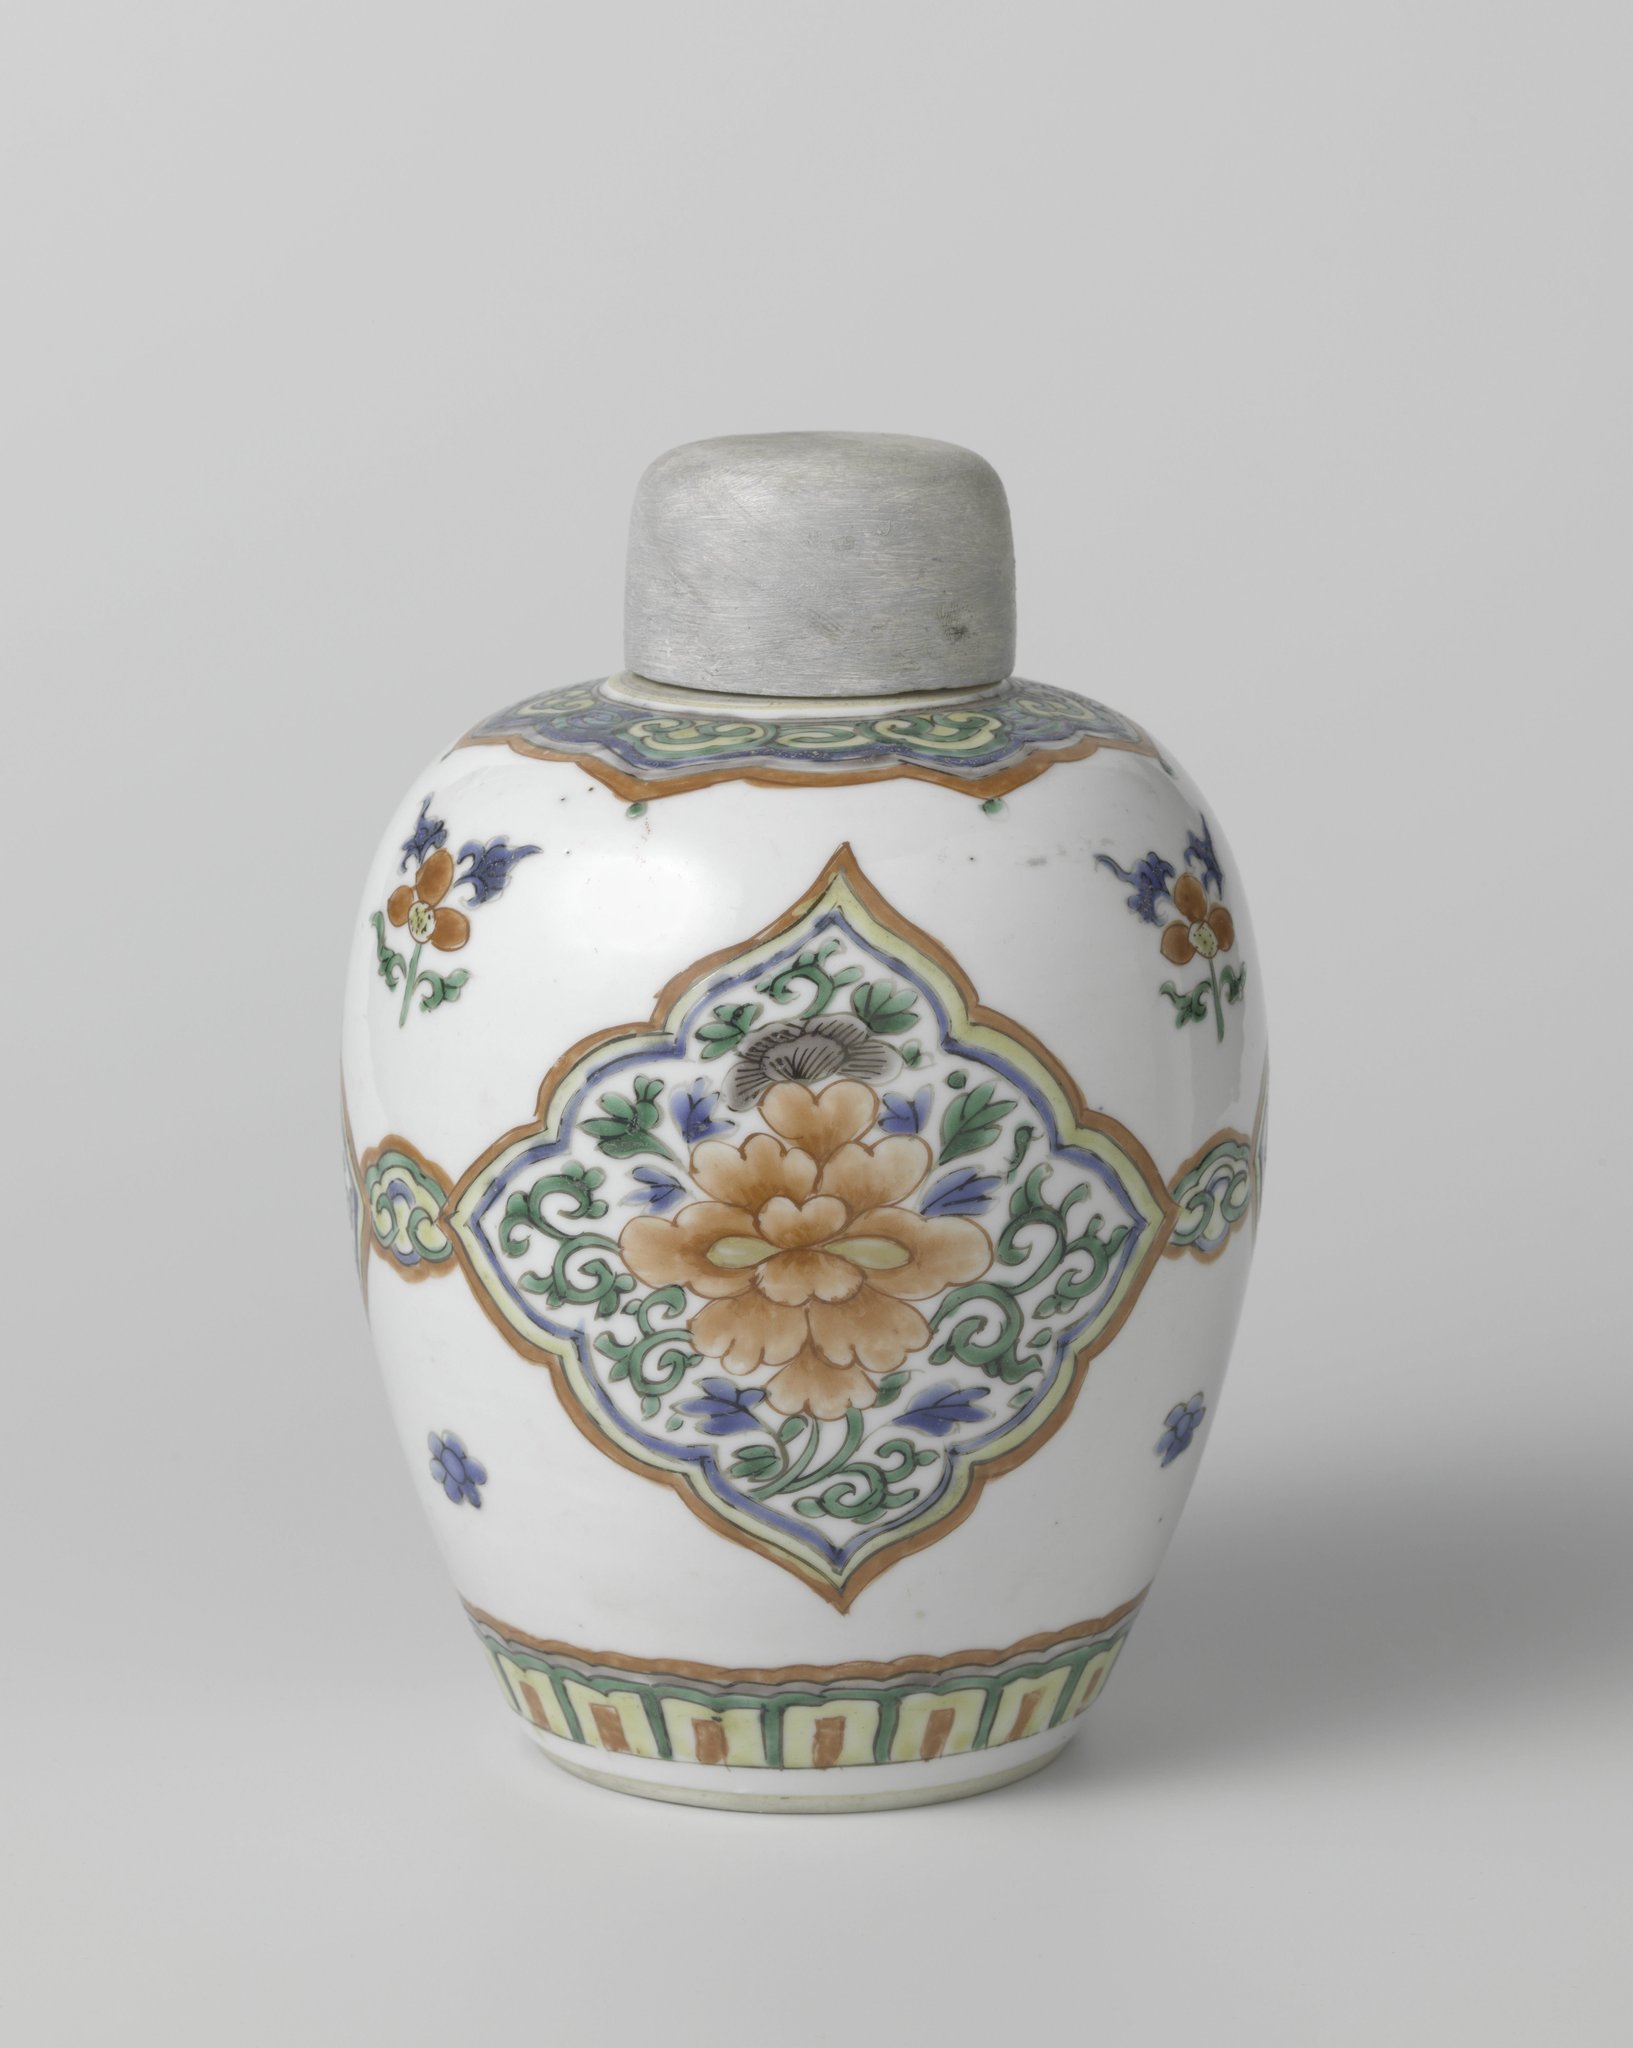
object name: pot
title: Covered jar with ruyi-heads and flowers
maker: Anonymous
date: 1700-1724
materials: glaze, paint, porcelain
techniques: firing, turning, vitrification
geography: china